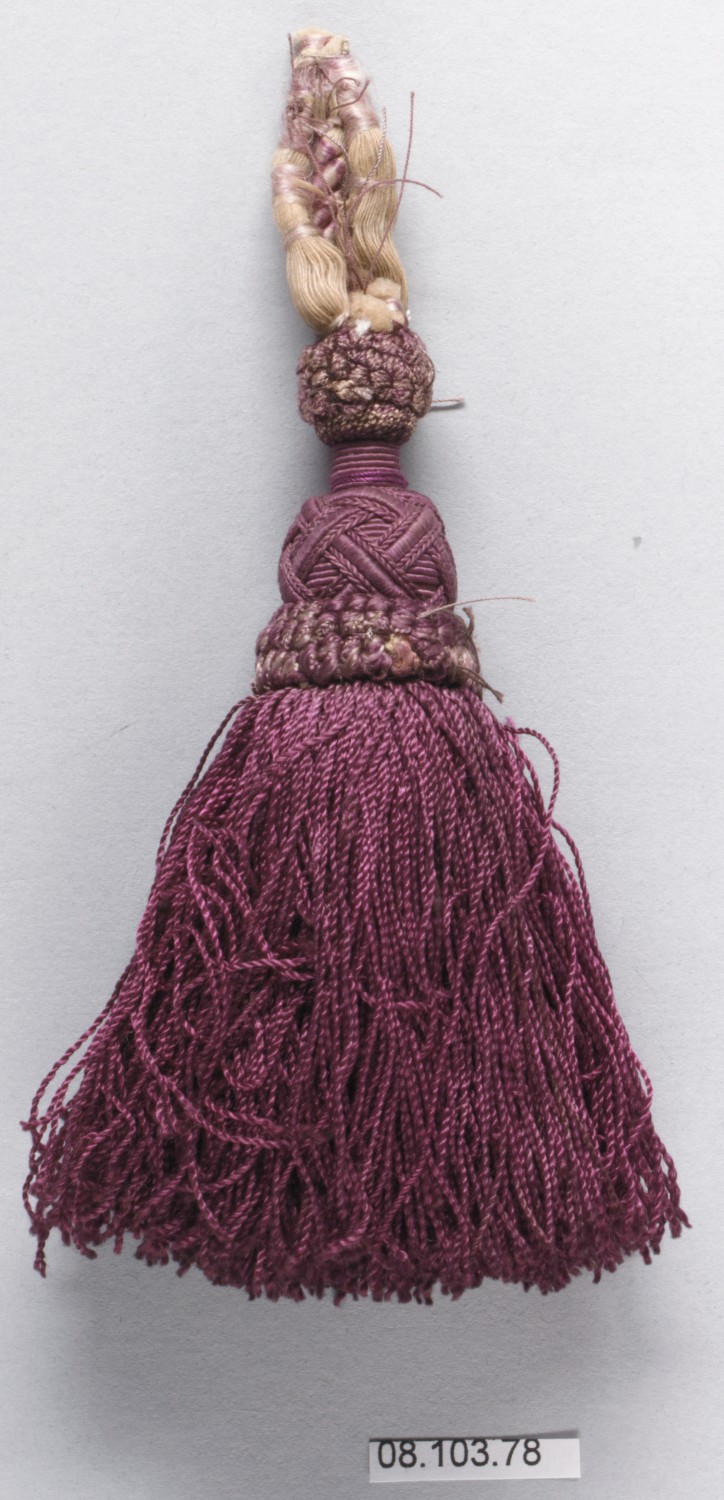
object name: tassel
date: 1801-1900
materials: silk